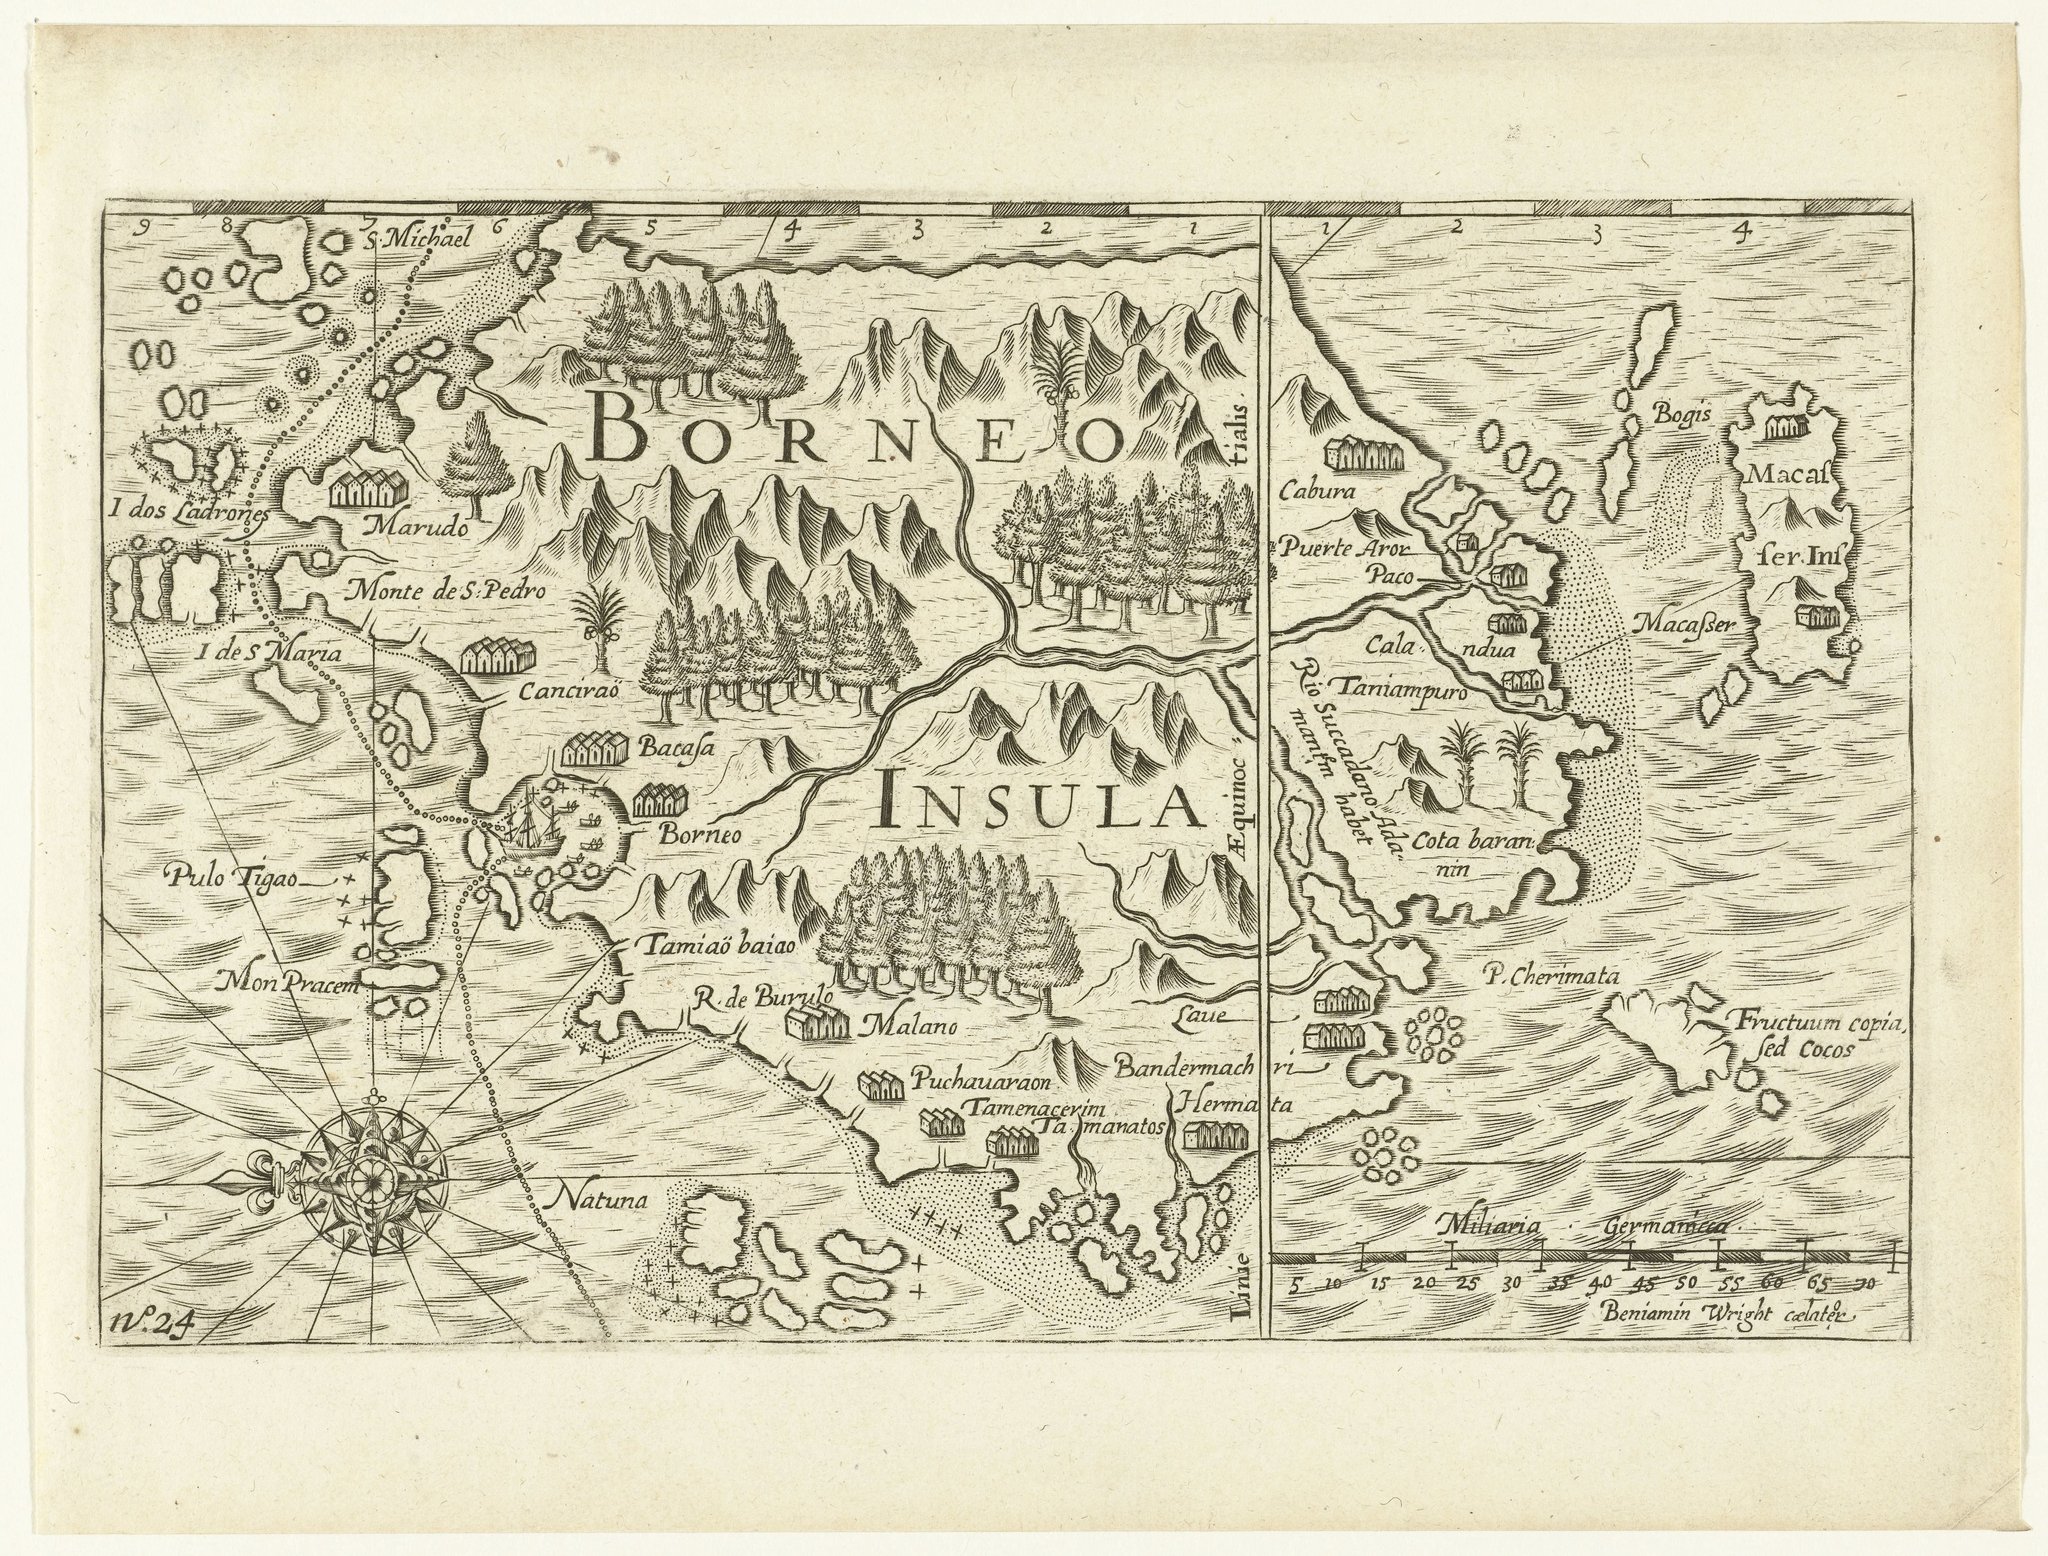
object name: print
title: Kaart van het eiland Borneo, 1601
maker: benjamin wright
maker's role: print maker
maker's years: 1574-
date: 1601-1602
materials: paper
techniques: engraving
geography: northern netherlands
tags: utrecht, maps of separate countries or regions, landscapes in tropical and sub-tropical regions, exploration, expedition, voyage of discovery, borneo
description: Gebruikt als illustratie eerst in: O. van Noort, Beschryvinghe vande voyagie om den geheelen werelt cloot, ghedaen door Olivier van Noort van Utrecht. ... door de Strate Magellanes, ... langs de custen van Cica, Chili ende Peru, om den gantschen aerden cloot, ende door de Molucques wederom thuys te comen. : Te zeyl gegaen van Rotterdam ... 1598. Ende ... weder ghekeert ... 1601. Daer in dat vertelt wort zyne wonderlijcke avontueren, Jan van Waesberge (II) te Rotterdam en Cornelis Claes te Amsterdam 1602. Later gebruikt in: Oost-Indische ende West-Indische voyagien, Michiel Colijn, Amsterdam 1619 en in deze staat eerst gebruikt in: Beschrijvinge van de Schipvaerd by de Hollanders ghedaen onder 't beleydt ende Generaelschap van Olivier van Noort, door de Straet of Engte van Magallanes, ende voorts de gantsche kloot des Aertbodems om. Opgenomen in: I. Commelin, Begin ende voortgangh, van de Vereenighde Nederlantsche Geoctroyeerde Oost-Indische Compagnie, J. Janssonius, Amsterdam 1646. Genummerd: 24.